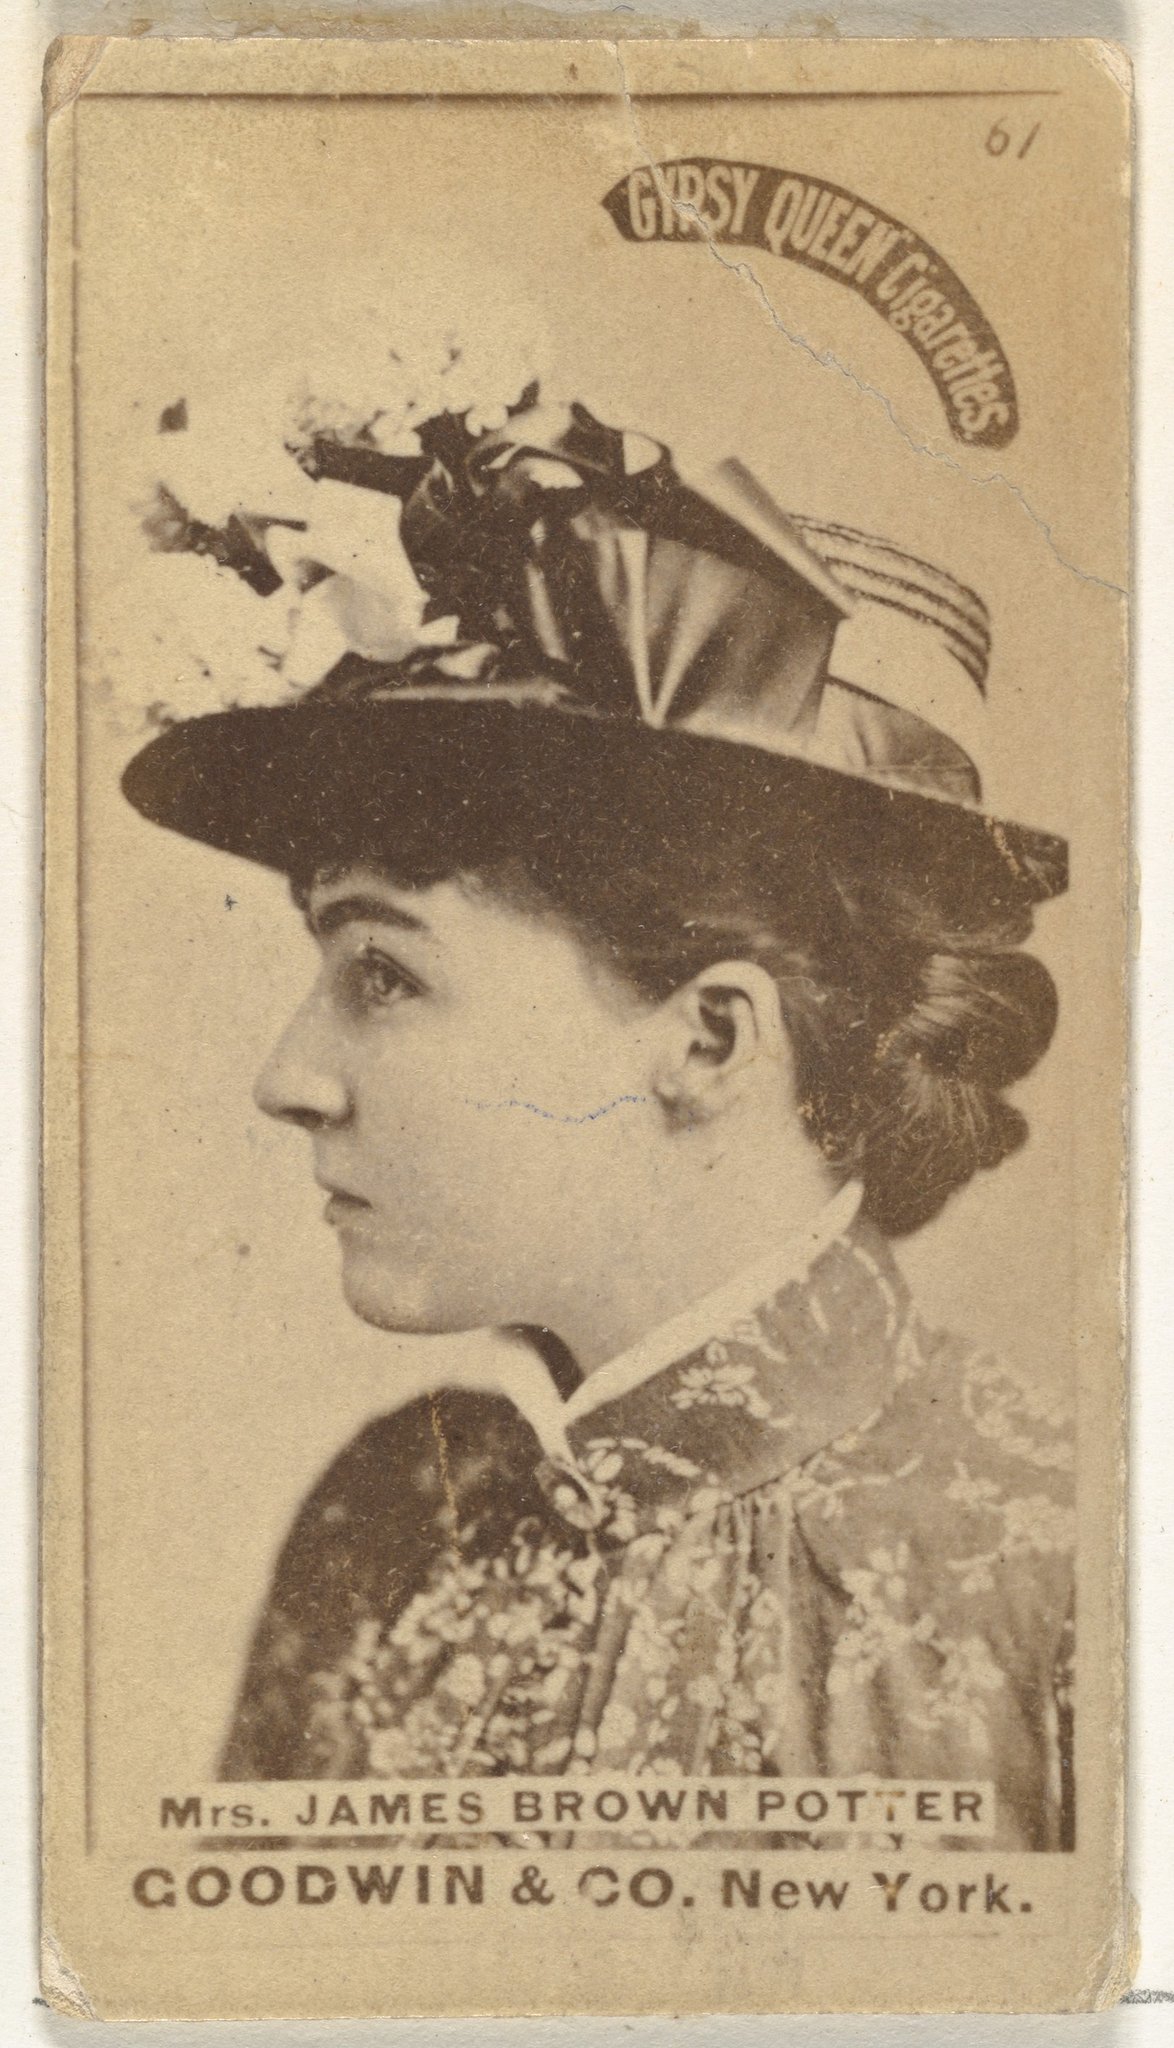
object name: photograph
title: Mrs. James Brown Potter, from the Actors and Actresses series (N171) for Gypsy Queen Cigarettes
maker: goodwin & company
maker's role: publisher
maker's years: 1850-1950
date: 1886-1890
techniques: albumen silver print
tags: portraits,women,actresses